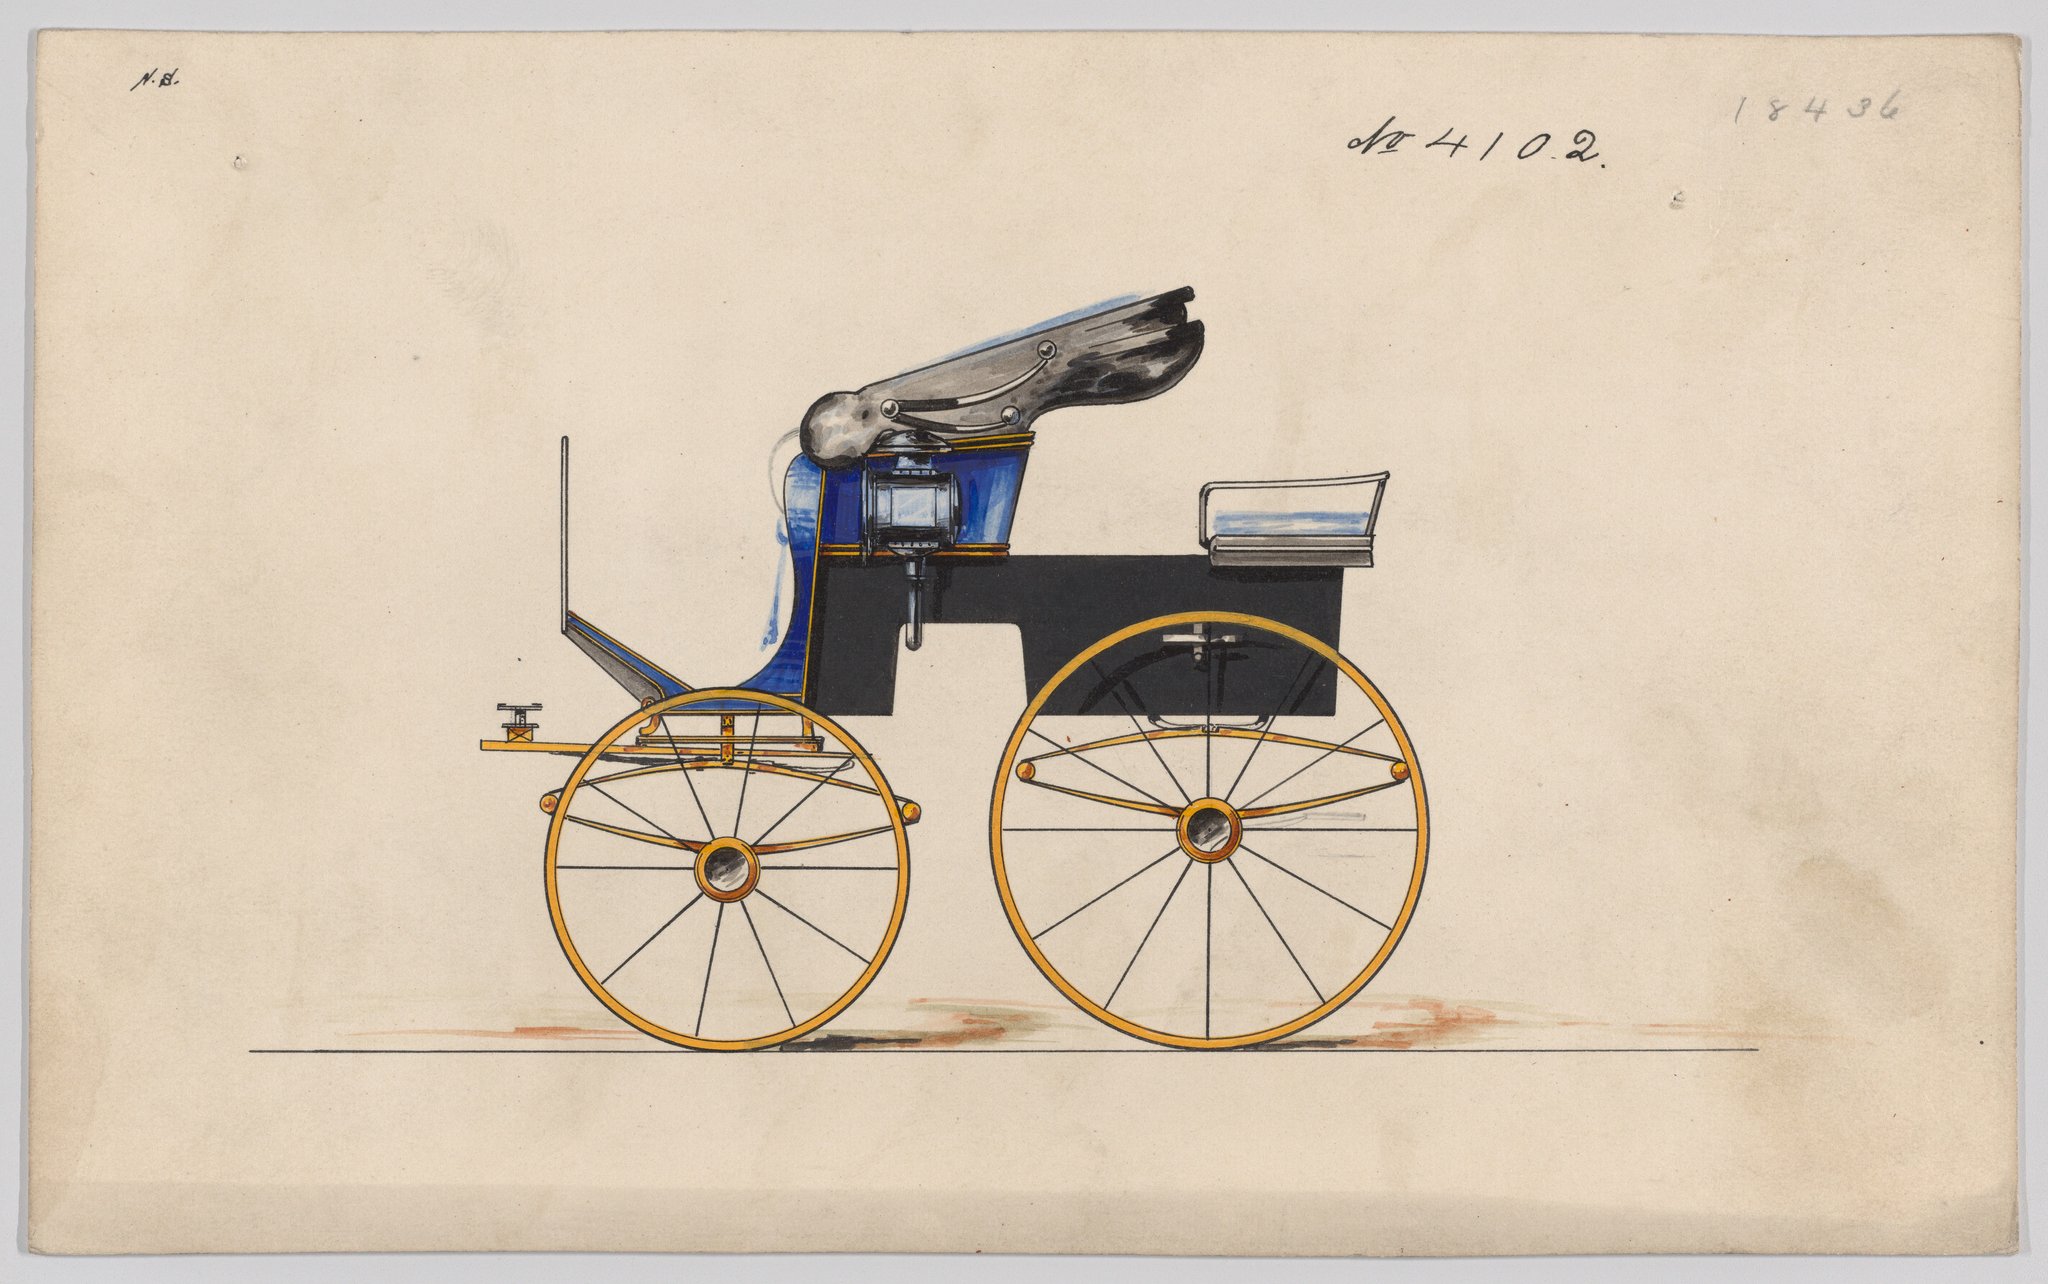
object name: drawing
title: Design for Stanhope Phaeton, no. 4102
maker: brewster & co.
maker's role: manufacturer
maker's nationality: american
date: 1890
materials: gouache, gum arabic, ink, watercolor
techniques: pen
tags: carriages